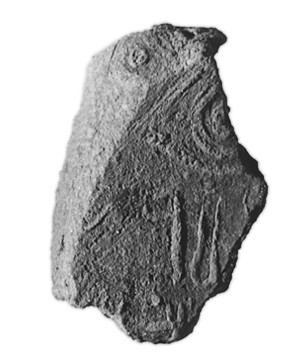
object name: sealing fragment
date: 2030-1640 BCE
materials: clay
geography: egypt